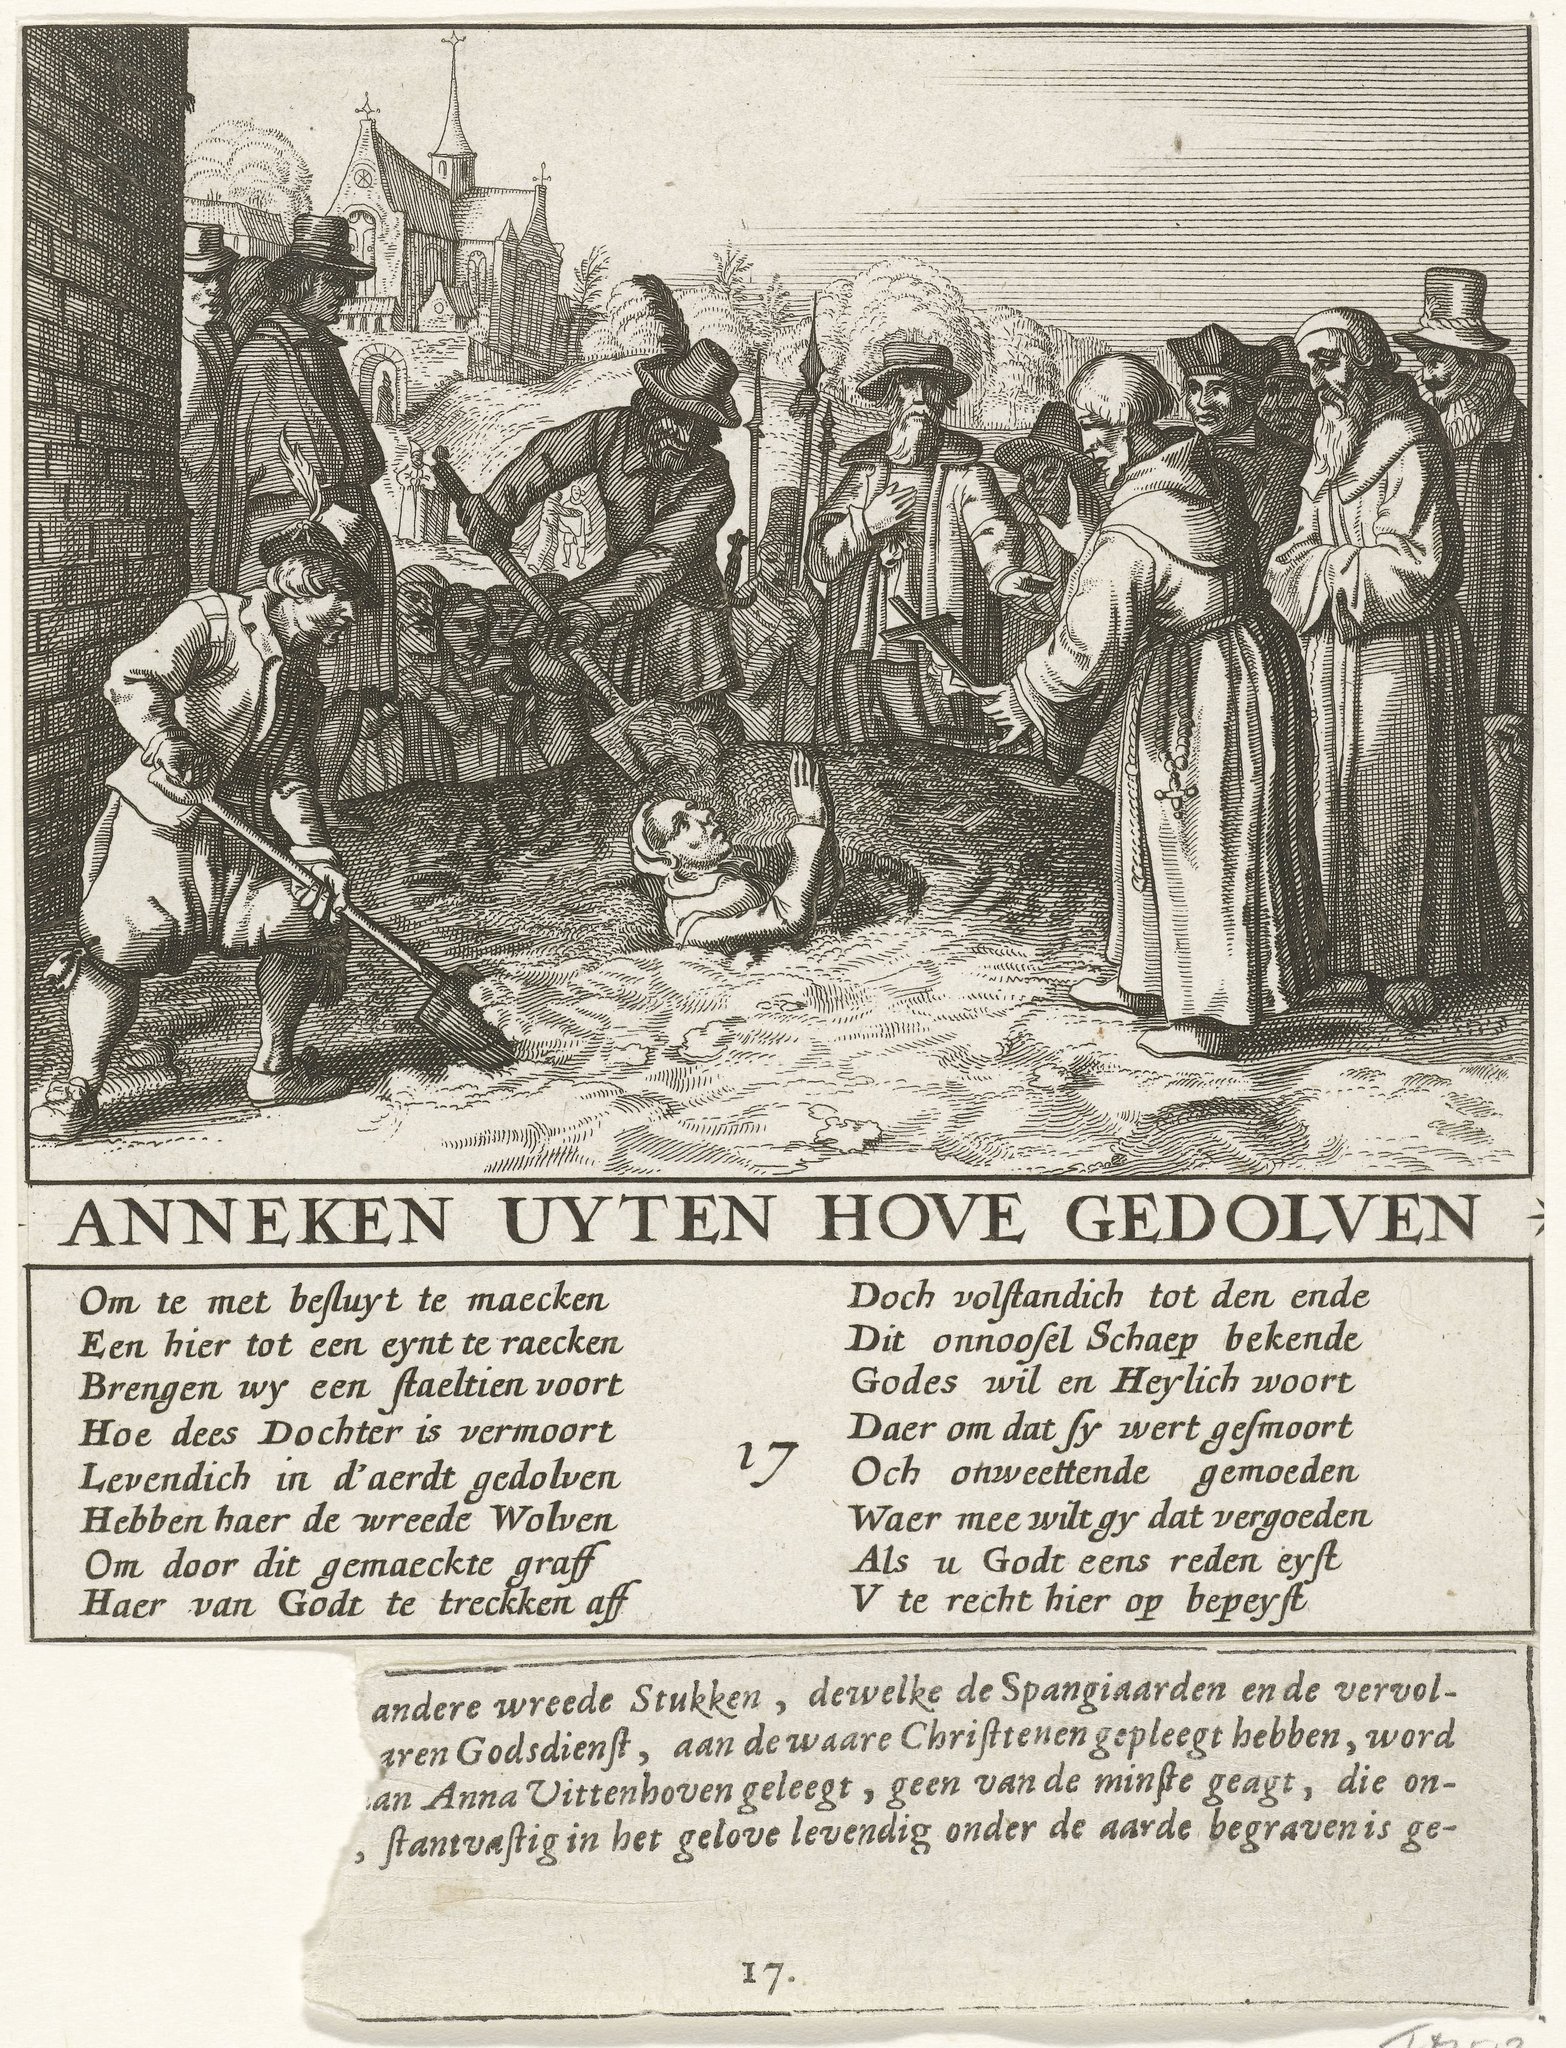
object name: history print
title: Anneken Uyten Hove gedolven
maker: Anonymous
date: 1618-1624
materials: paper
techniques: etching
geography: northern netherlands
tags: buried alive (violent death), execution of heretic, e.g. by burning at the stake, 'auto-da-fé', brussels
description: Illustratie voor een (onbekende) uitgave van het populaire en vaak herdrukte werk getiteld: De Spaensche Tiranye gheschiet in Nederlant, waarschijnlijk voor het eerst ca. 1620 verschenen. Zie ook Hollstein (Dutch), vol. XXXVIII (Claes Jansz. Visscher II), p. 165, nr. 425 en een andere versie van dit werk uitgegeven in 1621 te Amsterdam bij C.L. vander Plasse, in de collectie van de Rijksmuseum Research Library, signatuur 327 K 30.